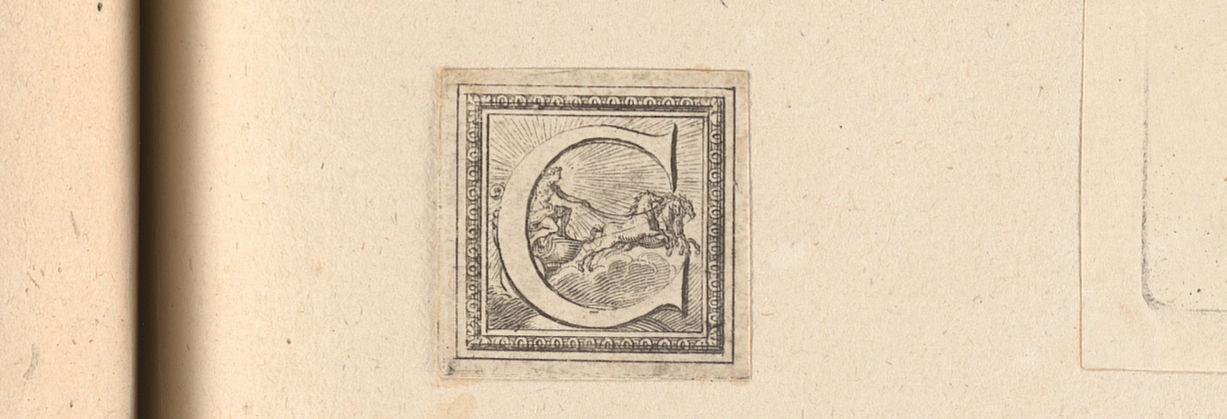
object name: book illustration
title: Initaal 'C' met Apollo in zijn kar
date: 1687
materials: paper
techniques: etching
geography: versailles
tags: apollo in the chariot of the sun, drawn by four horses, usually preceded by aurora holding a torch; 'carro del sole' (ripa)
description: Initiaal uit: Rainssant, Pierre. Explication des tableaux de la galerie de Versailles (...). Versailles: François Muguet, 1687.